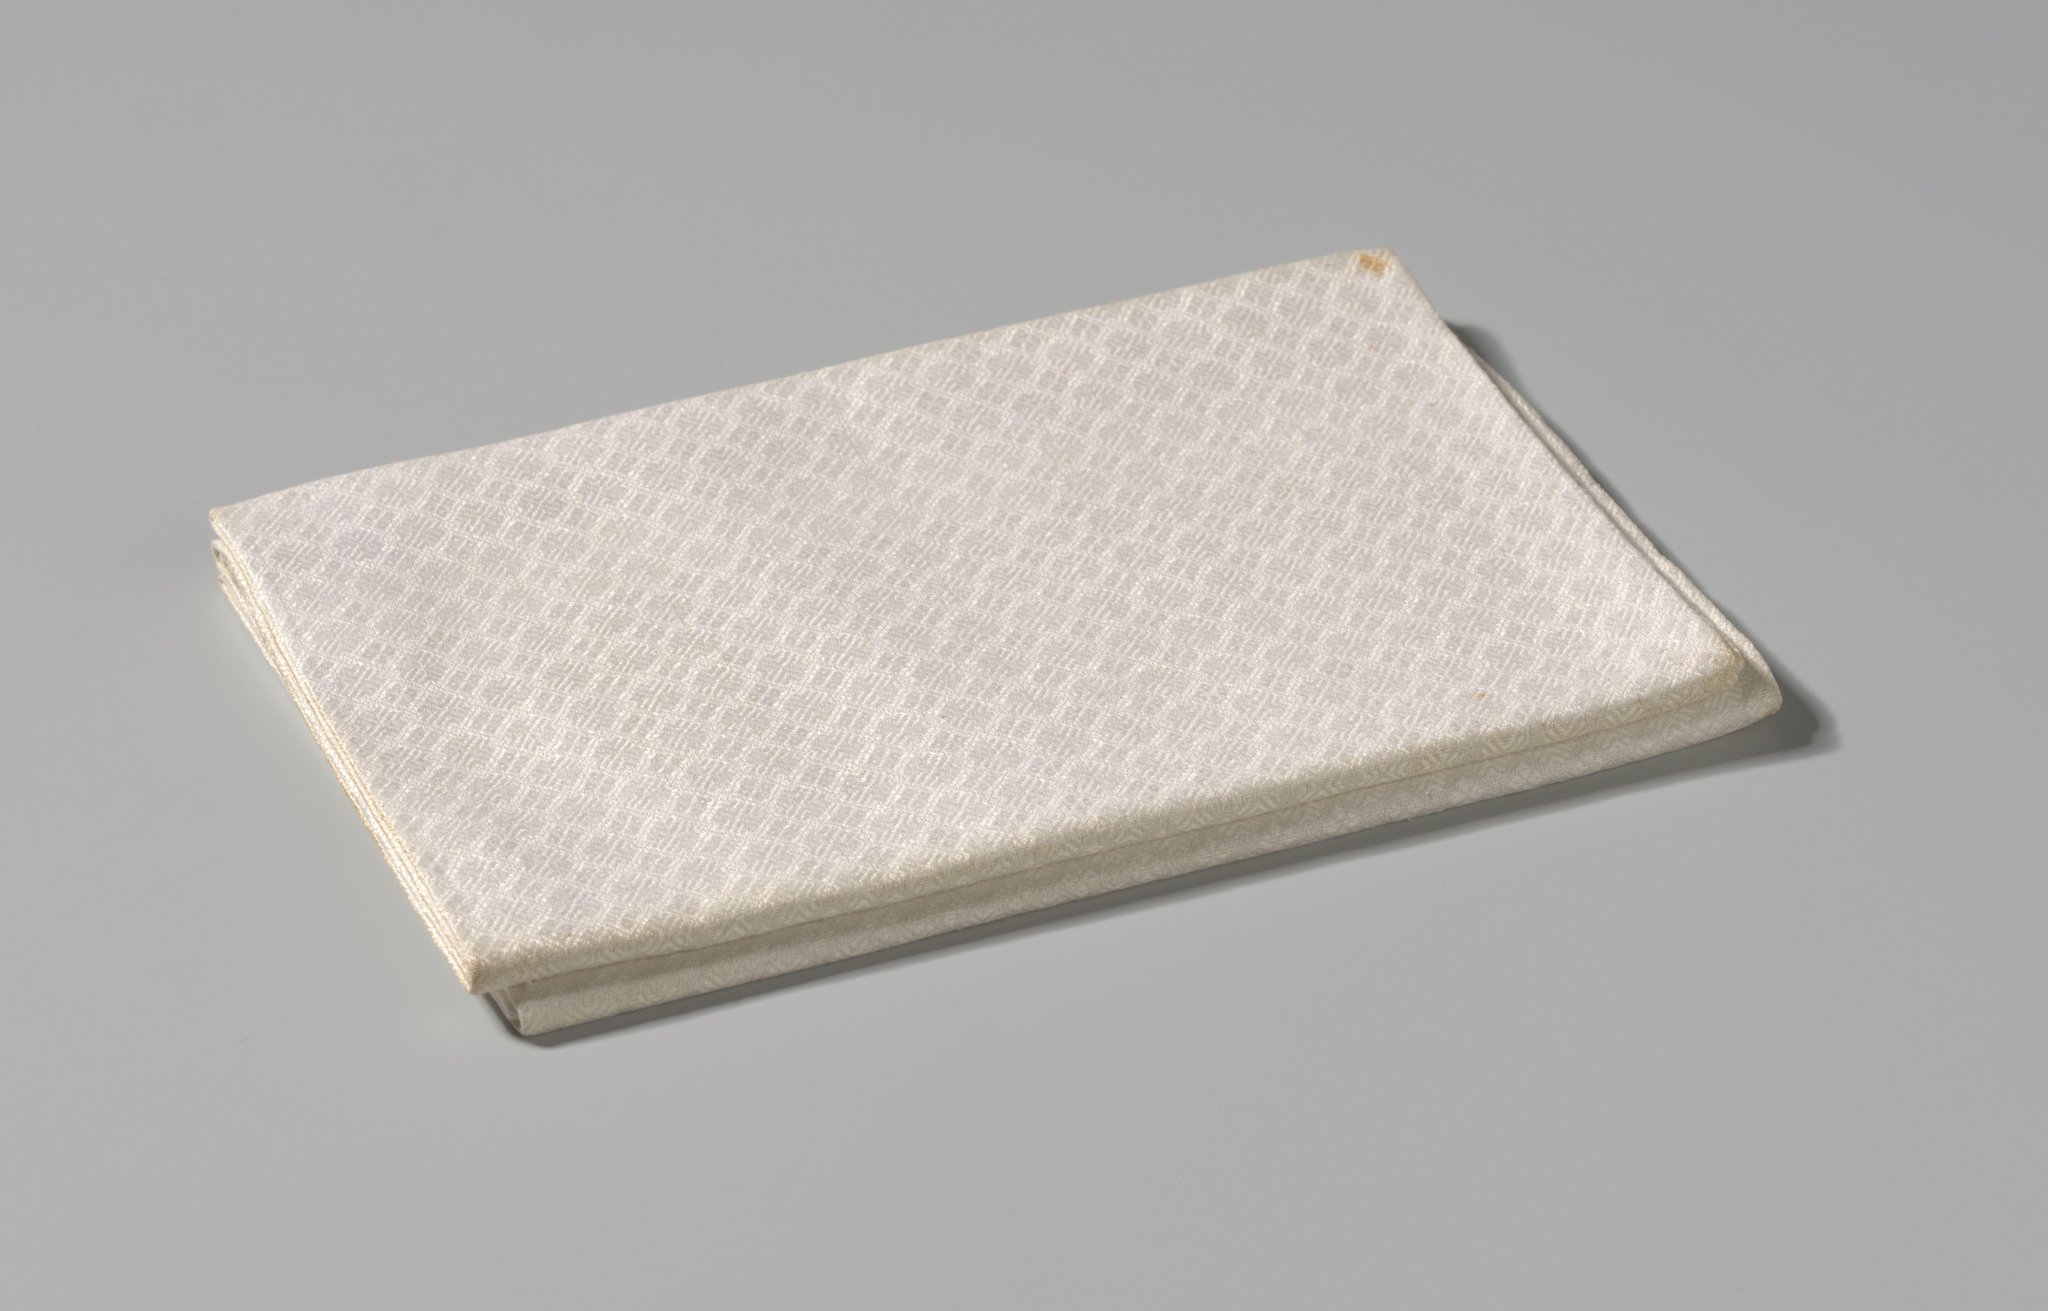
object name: napkin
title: Servet van wit linnen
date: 1767-1816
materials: linen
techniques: weave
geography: northern netherlands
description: Wit linnen servet met een kepervariatie-patroon, merk HW 20.